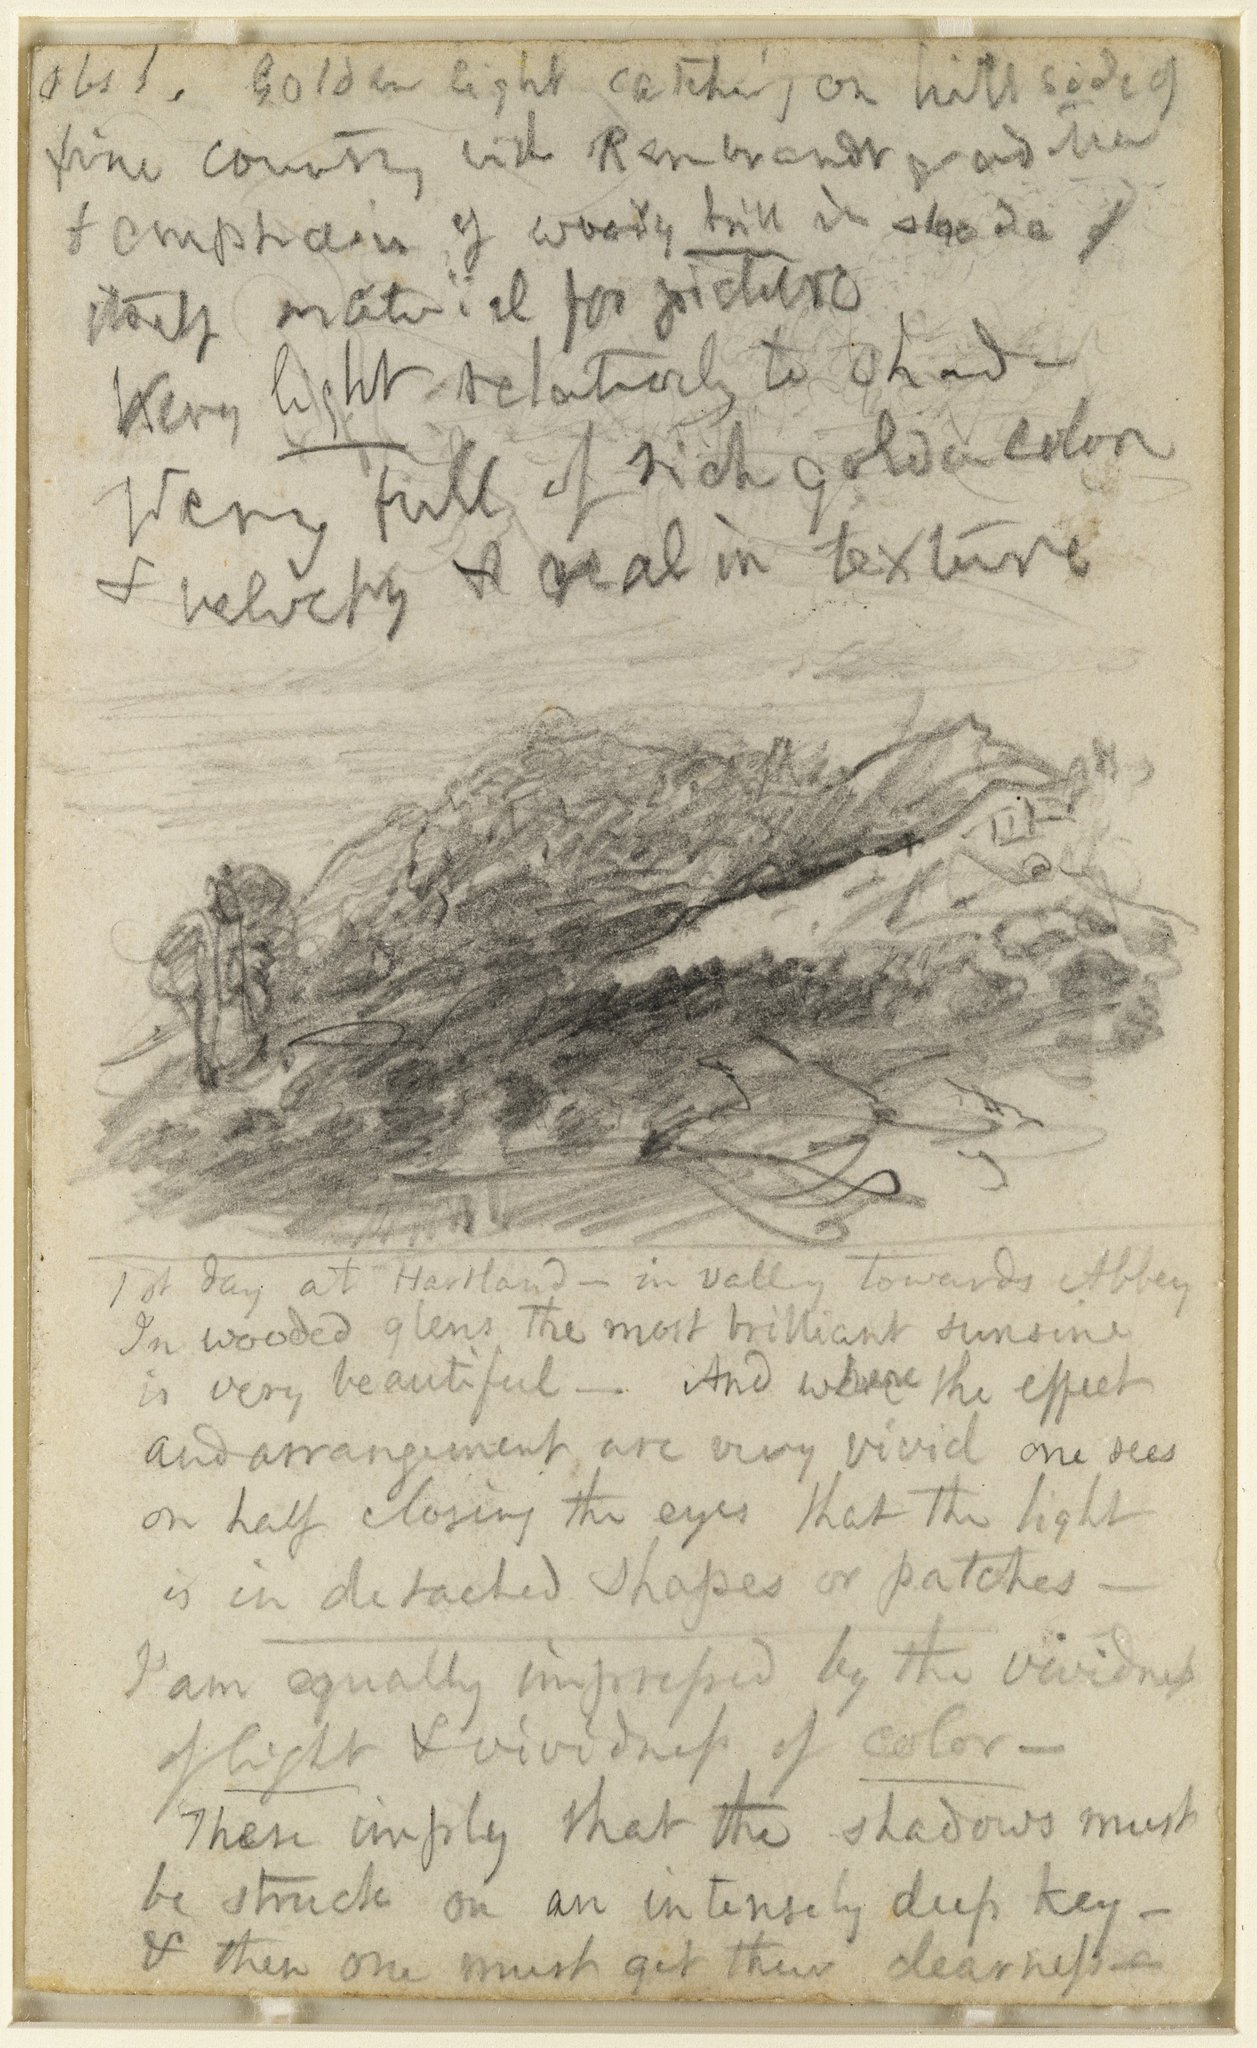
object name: drawing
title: Page from a sketchbook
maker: samuel palmer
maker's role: artist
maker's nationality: british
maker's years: 1805-1881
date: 1848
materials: graphite